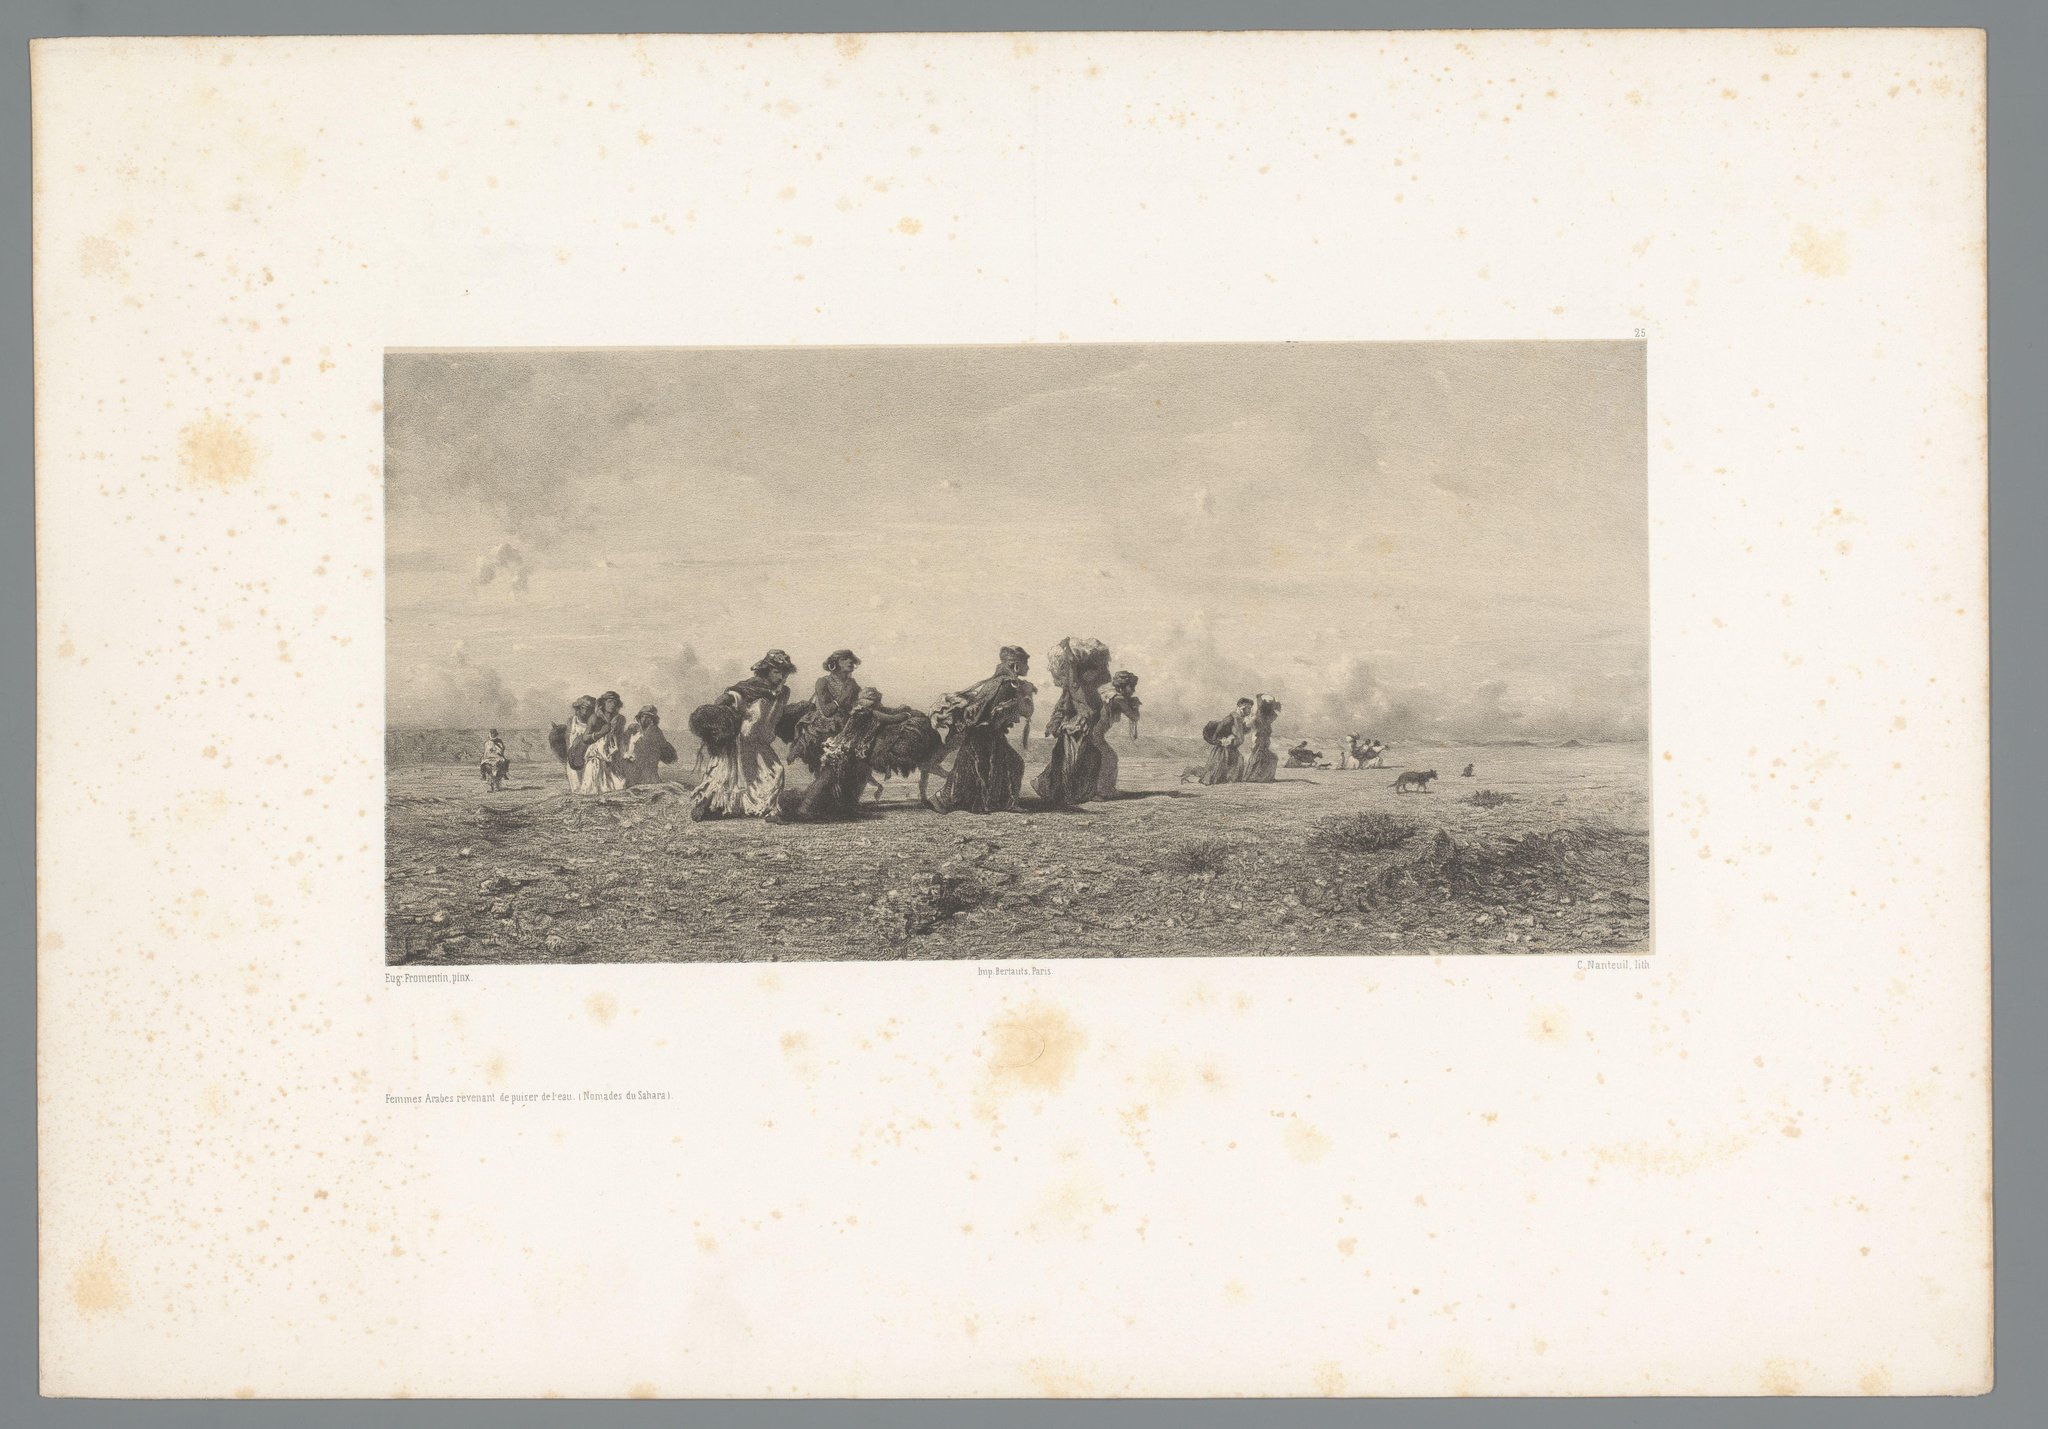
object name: print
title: Femmes Arbes revenant de puiser de l'eau. (Nomades du Sahara)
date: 1848-1862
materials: paper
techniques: lithograph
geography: paris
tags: hoofed animals: camel, wandering communities: nomads, female sex; woman, desert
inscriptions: check stamp: Lugt 36a